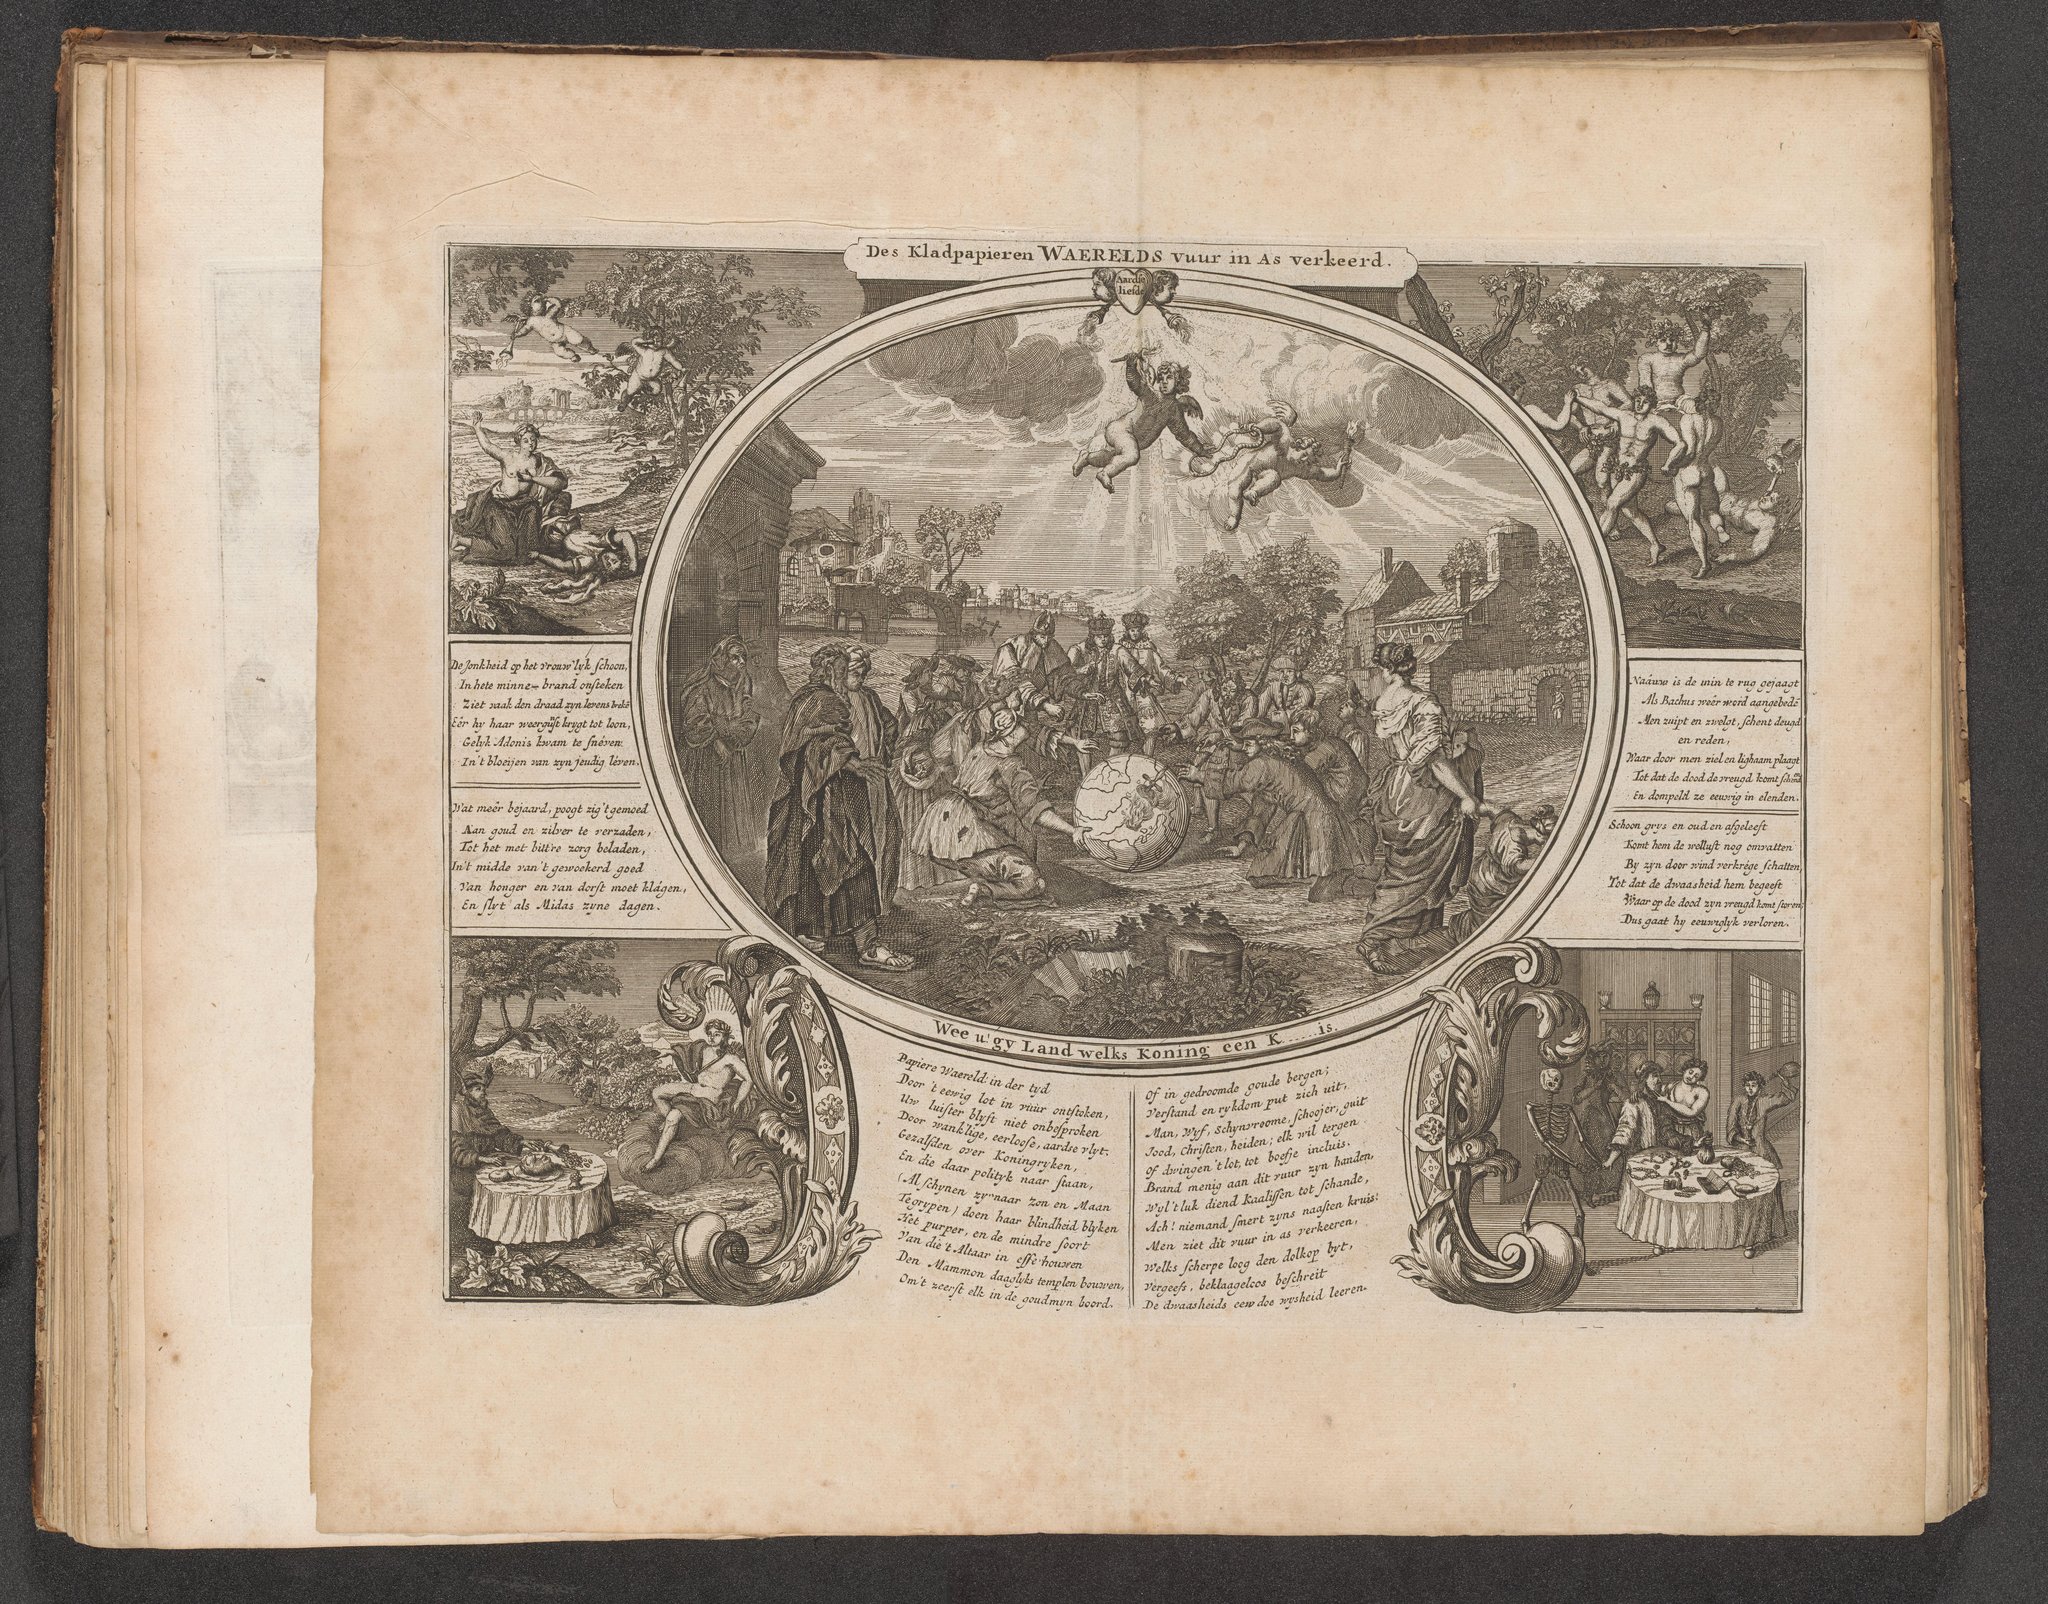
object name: cartoon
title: De kladpapieren wereld in brand, 1720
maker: Anonymous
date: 1720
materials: paper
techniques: engraving, etching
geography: northern netherlands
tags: scenes symbolizing 'vanitas'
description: Centrale voorstelling met de wereldlijke en geestelijke vorsten en allerlei ander volk van arm tot rijk zijn verzameld om een wereldbol die vlam vat. In de vier hoeken illsutraties van de vluchtigheid van de wereldse genoegens. Met meerdere verzen. Prent in de gebonden vierde uitgave (304 B 12) van Het Groote Tafereel der Dwaasheid met spotprenten op de Windhandel of Actiehandel van 1720.